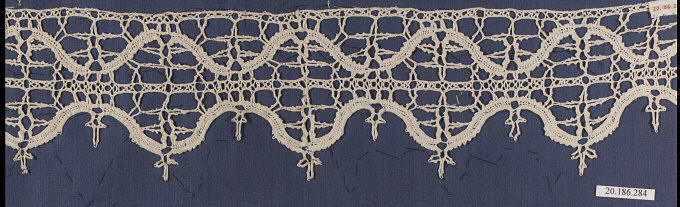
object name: edging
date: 1601-1700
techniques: lace